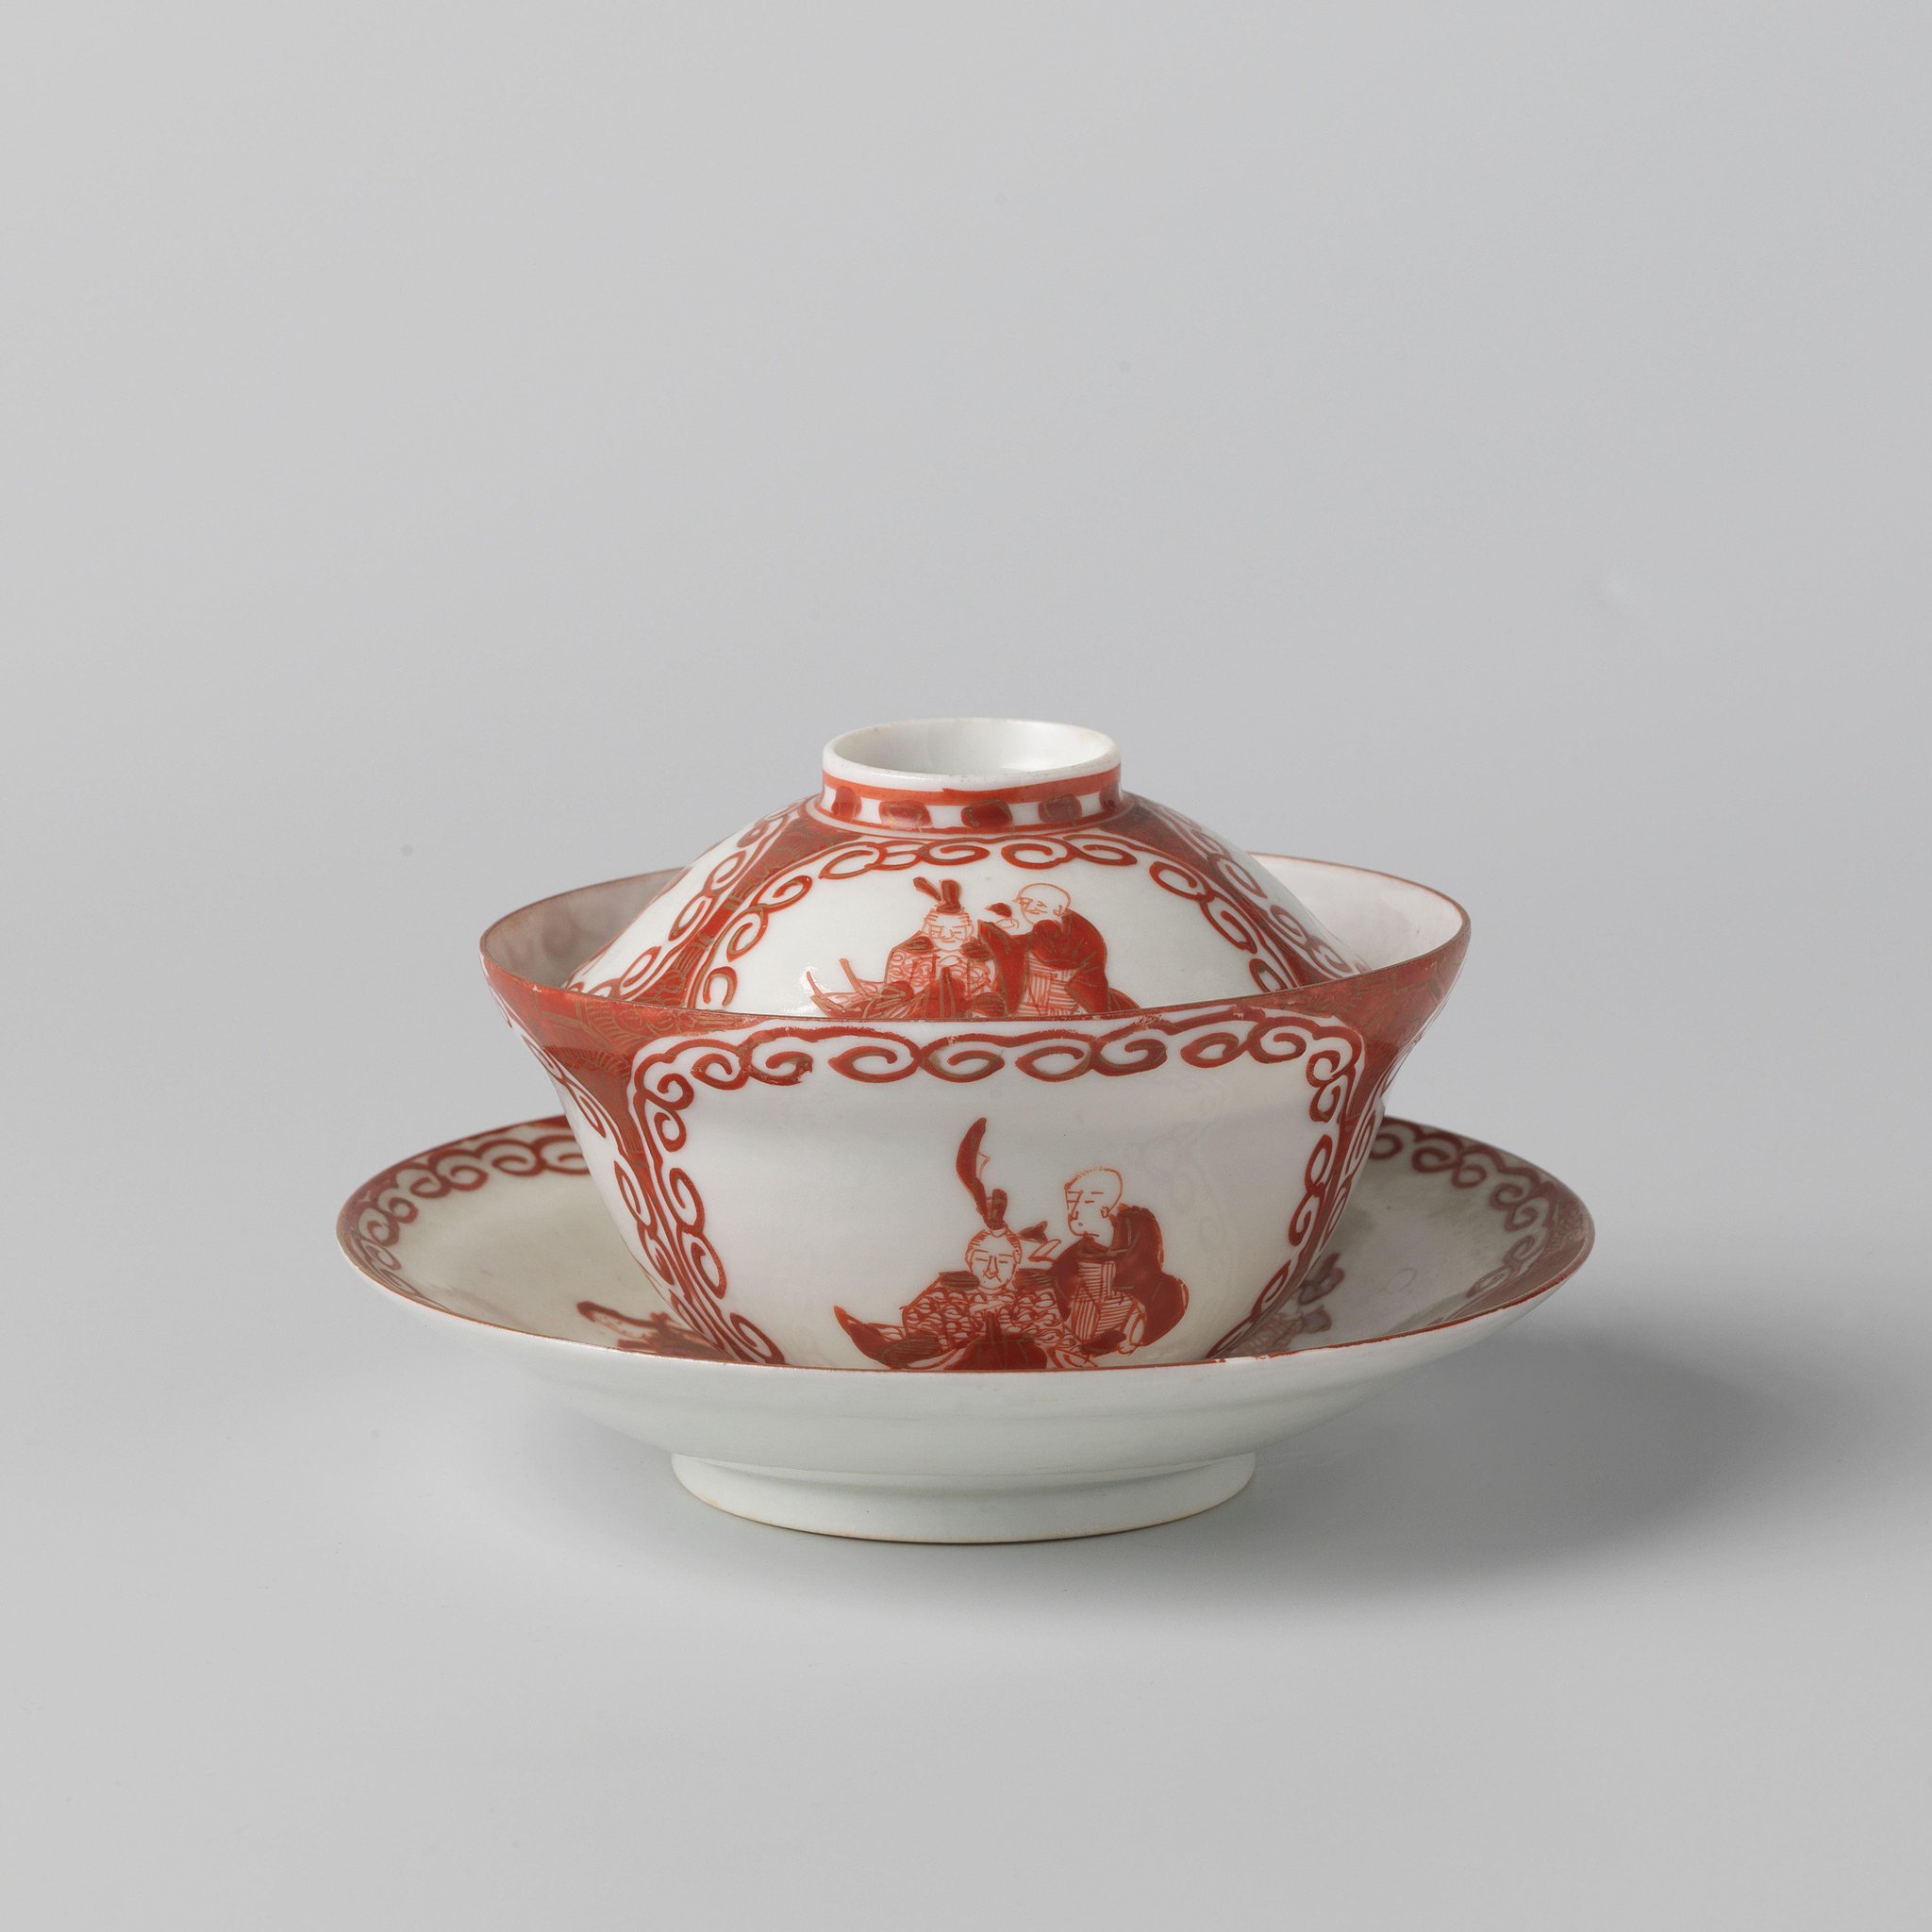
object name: cup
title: Covered cup with three panels with two seated figures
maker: Anonymous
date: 1800-1899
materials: glaze, gold, paint, porcelain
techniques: firing, gilding, turning, vitrification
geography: japan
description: Klokvormige dekselkop van porselein, beschilderd op het glazuur in rood en goud. Op de wand van de kop drie cartouches met telkens twee zittende mensen omgeven door een band krulwerk; tussen de cartouches een geometrisch patroon. Gemerkt op de onderzijde met drie ongeïdentificeerde karakters.